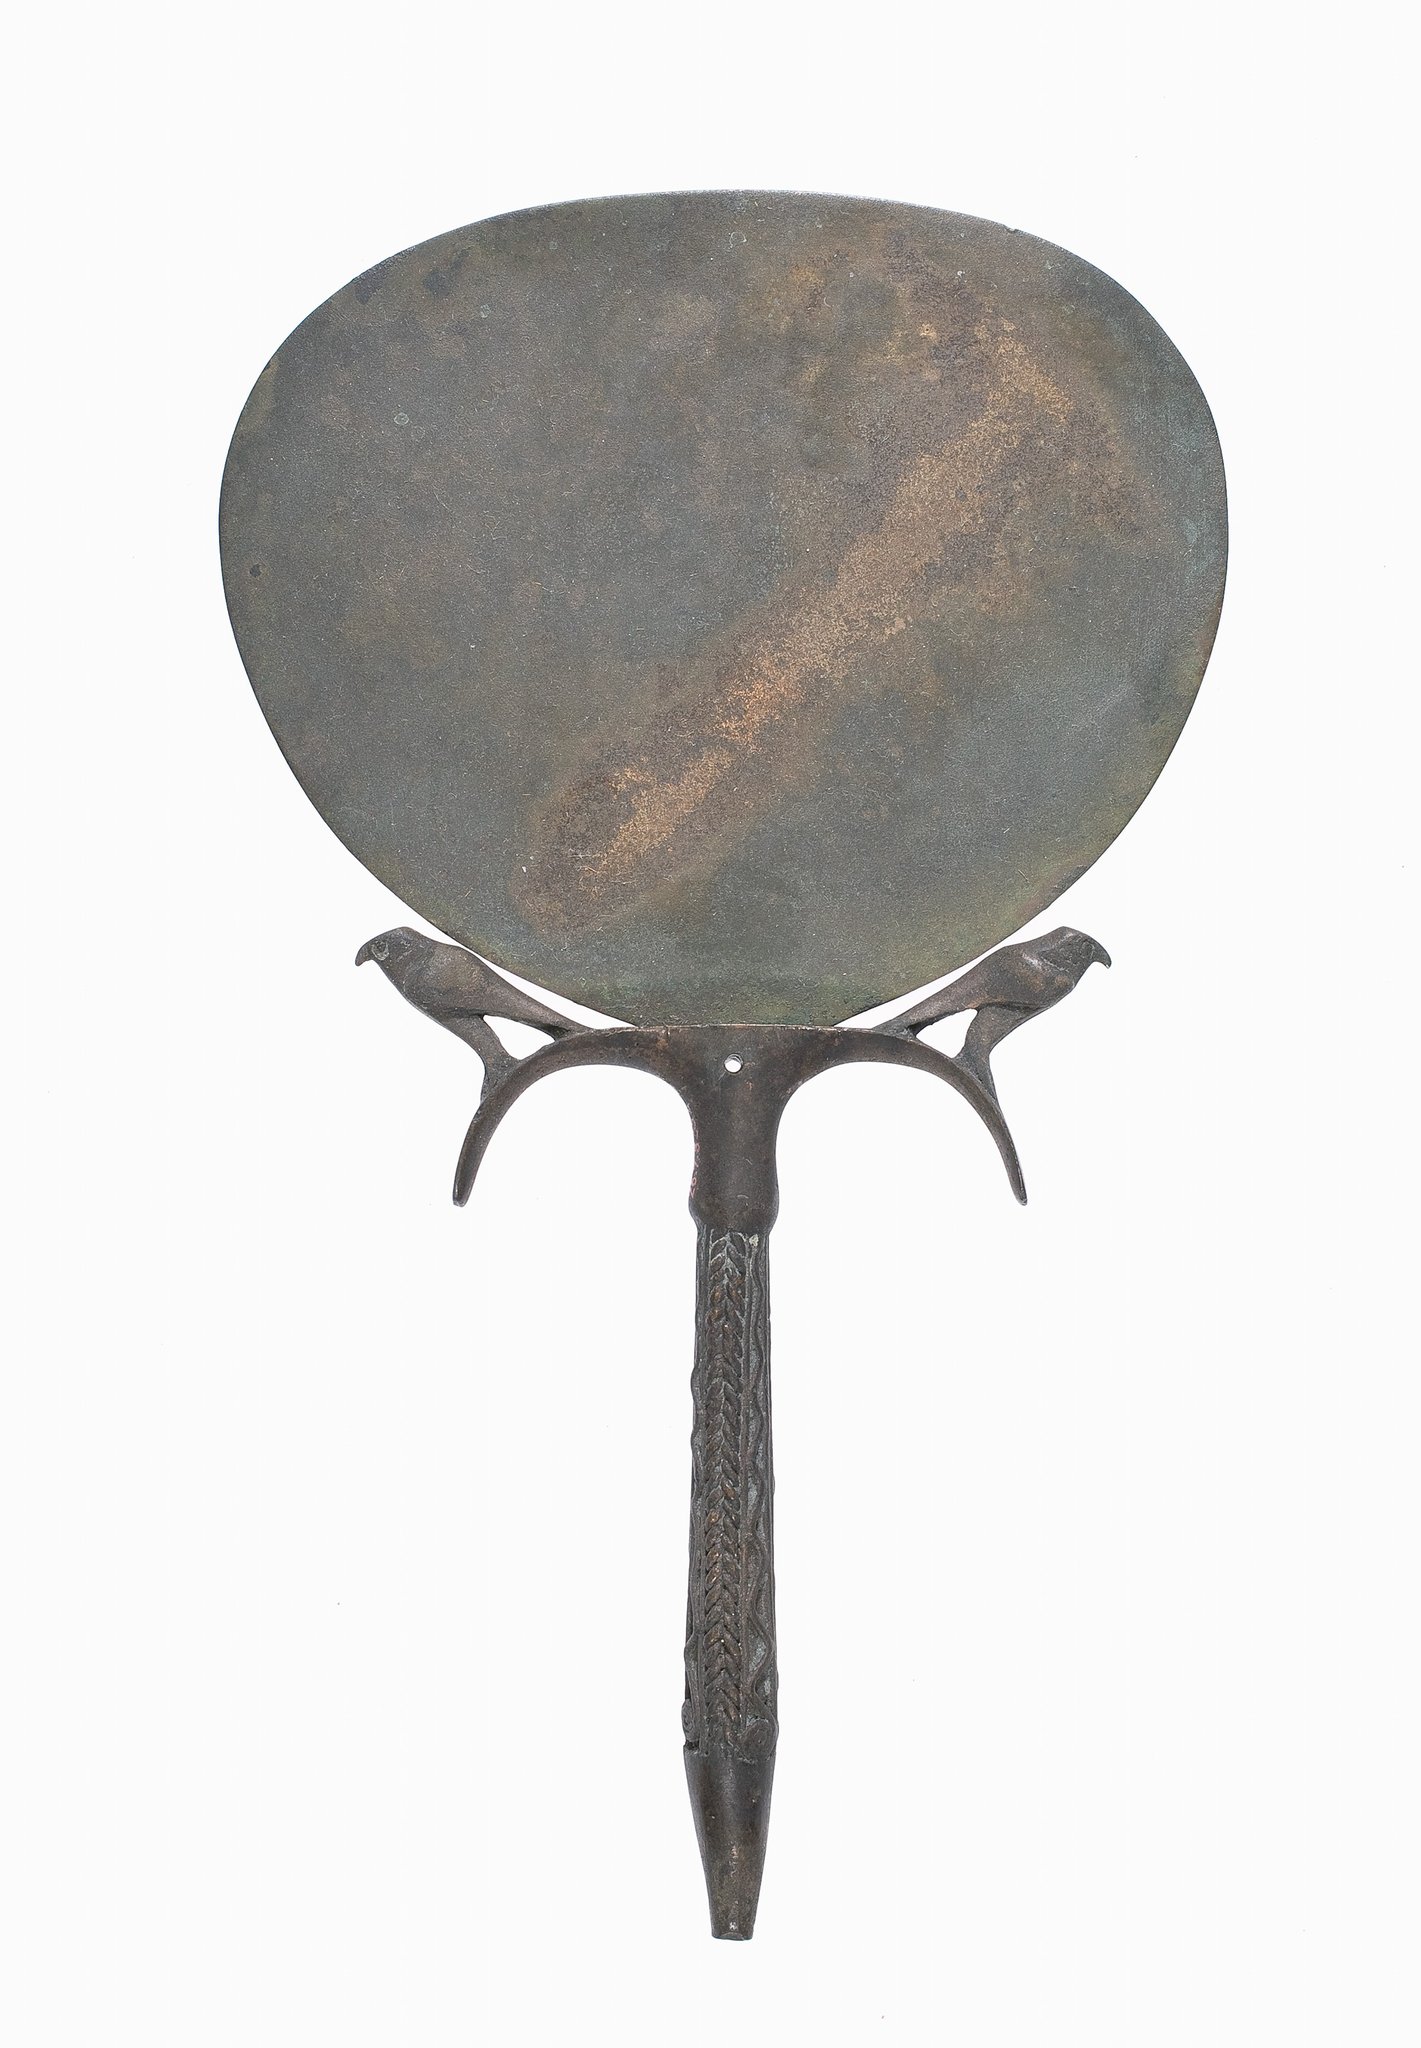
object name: mirror, falcon, payprus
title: Mirror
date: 1550-1295 BCE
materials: bronze, copper alloy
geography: egypt